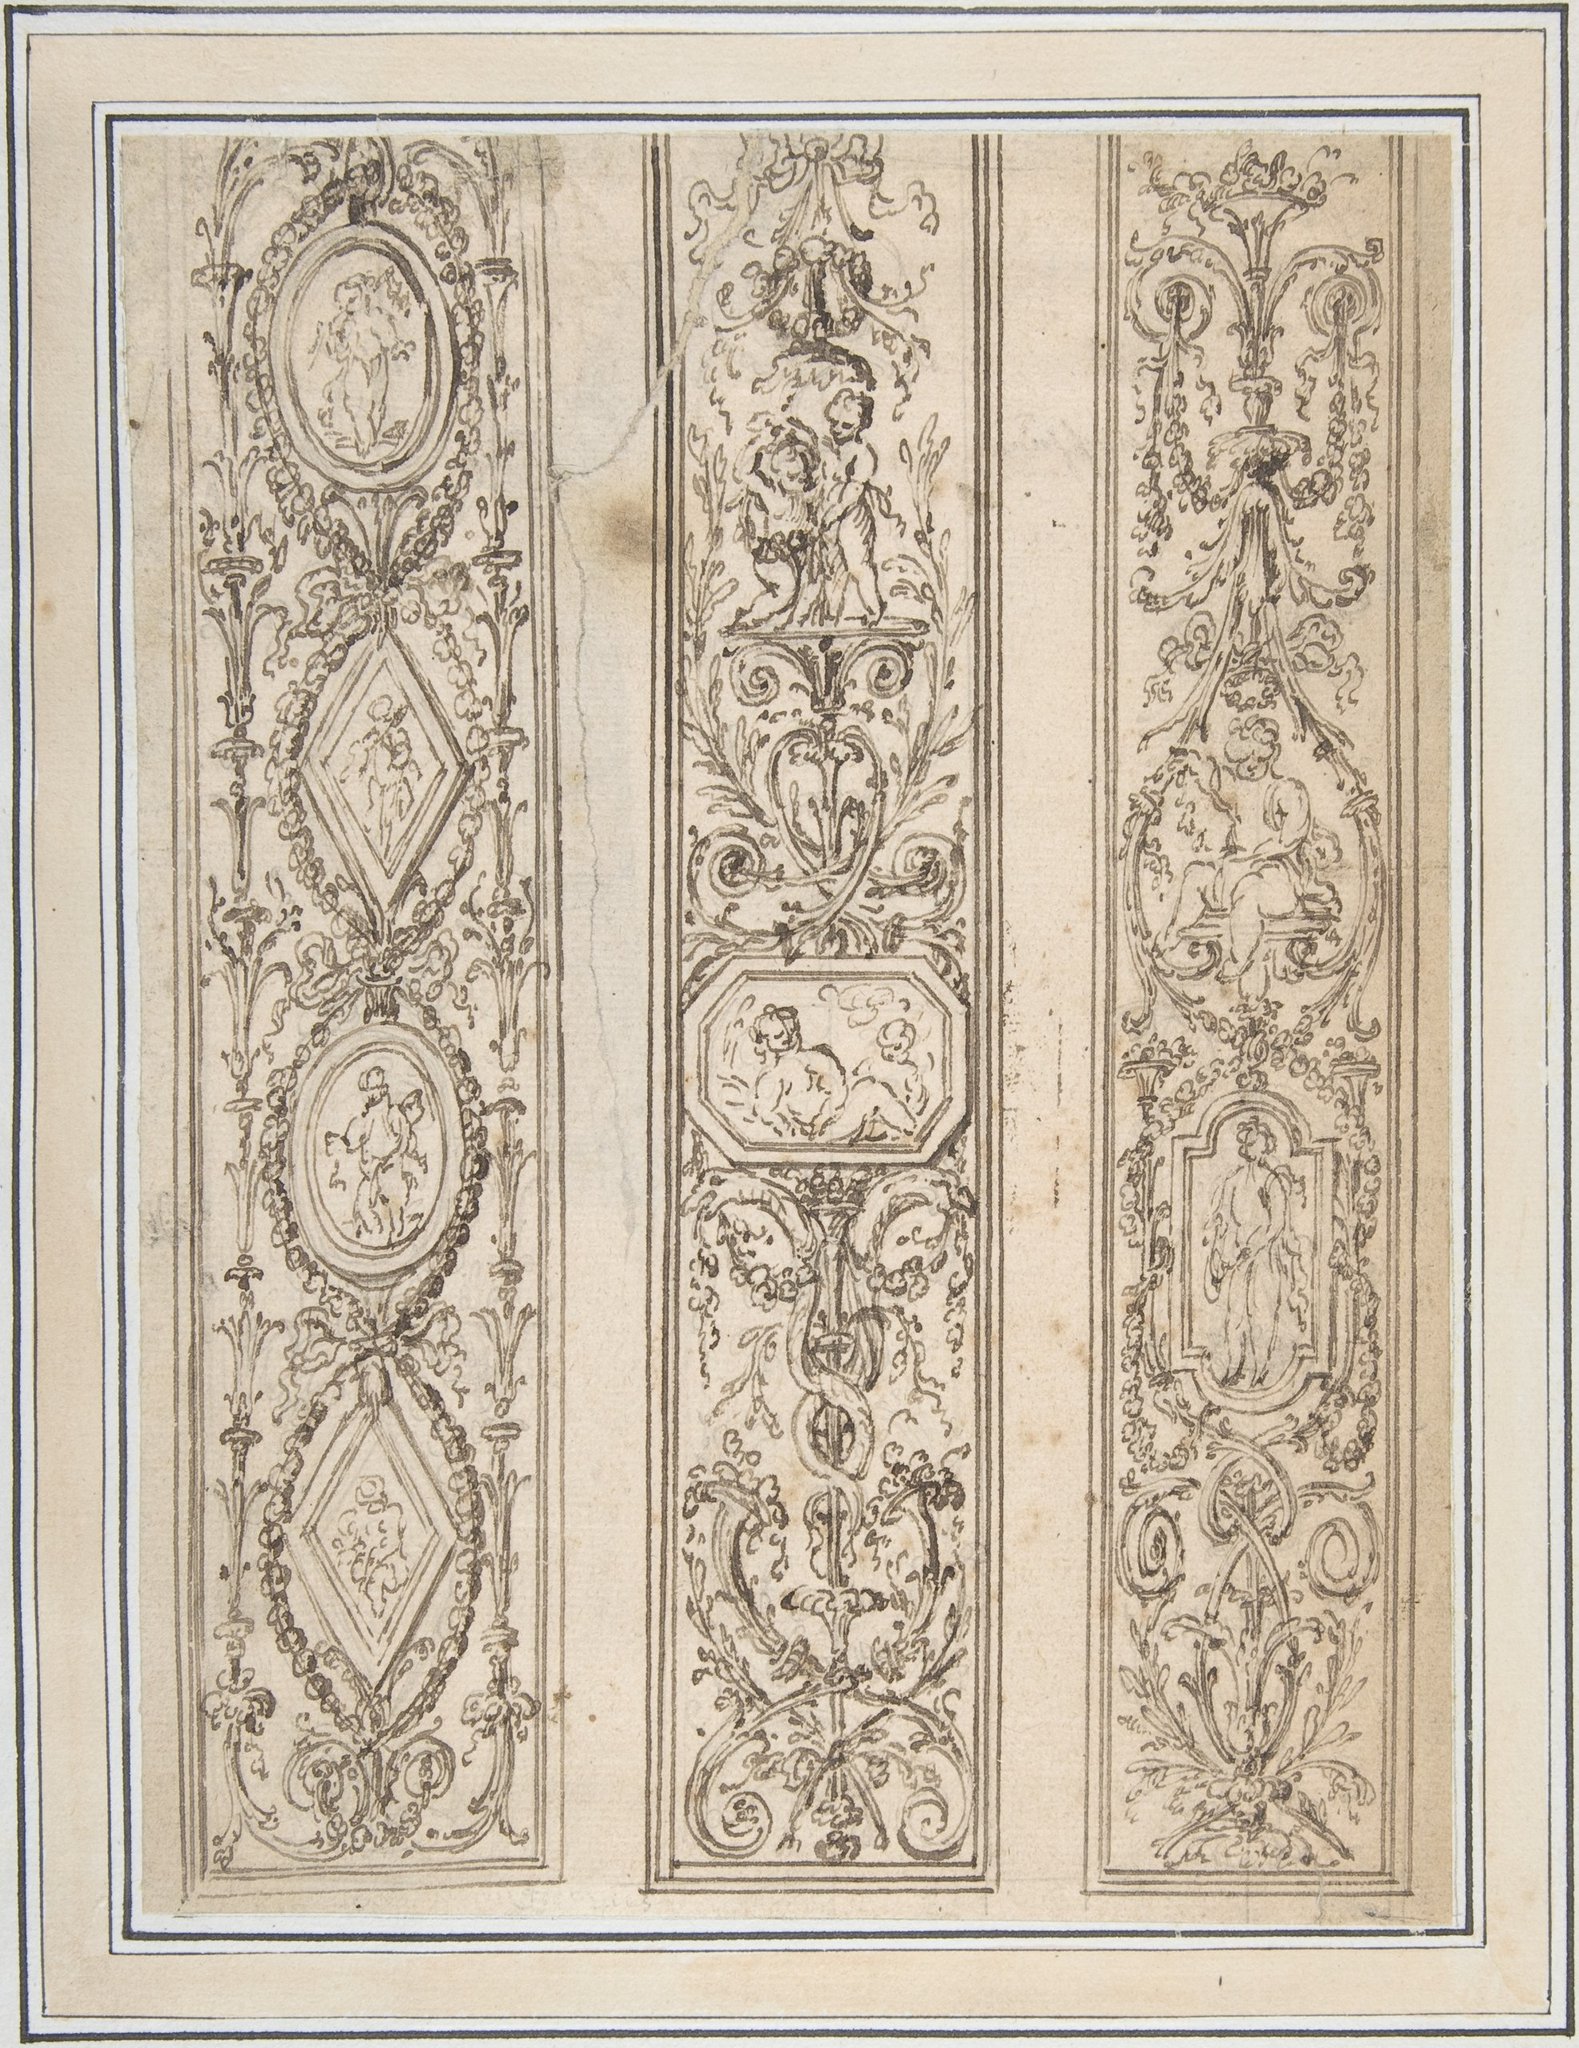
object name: drawing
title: Design for Three Upright Panels of Ornament Arabesques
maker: anonymous, french, 18th century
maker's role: artist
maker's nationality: french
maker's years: 1700-1800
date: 1701-1800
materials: ink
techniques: pen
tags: ornament